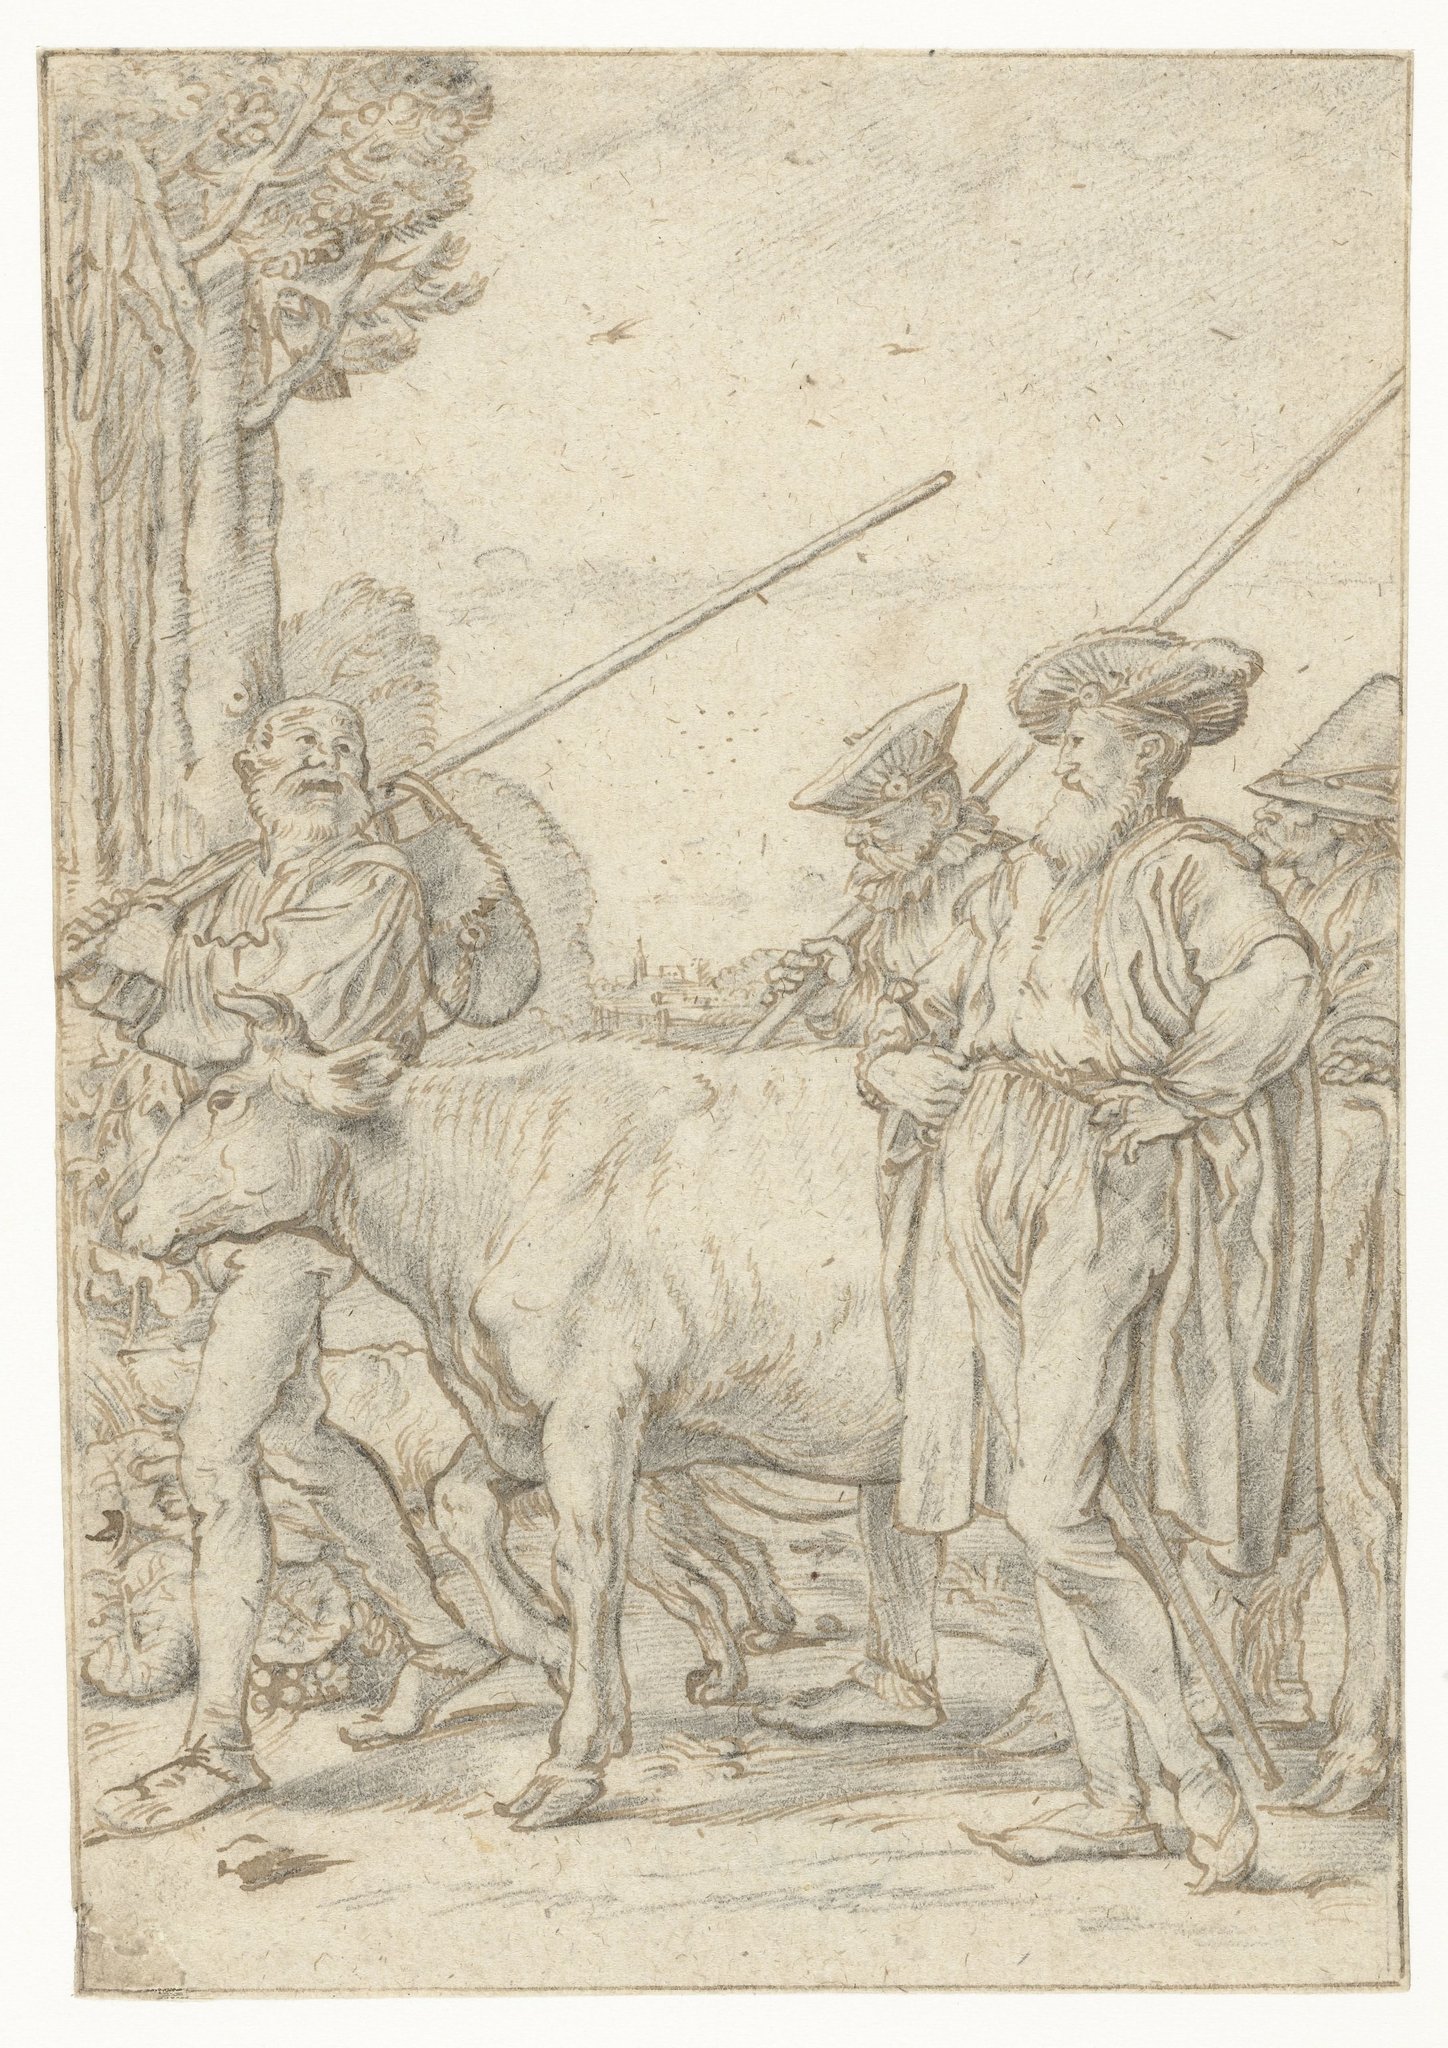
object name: drawing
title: De rechtspraak van Graaf Willem III de Goede, eerste reeks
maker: willem pietersz buytewech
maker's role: draughtsman, print maker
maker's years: 1592-1624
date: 1618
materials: chalk, ink, paper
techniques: pen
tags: cow